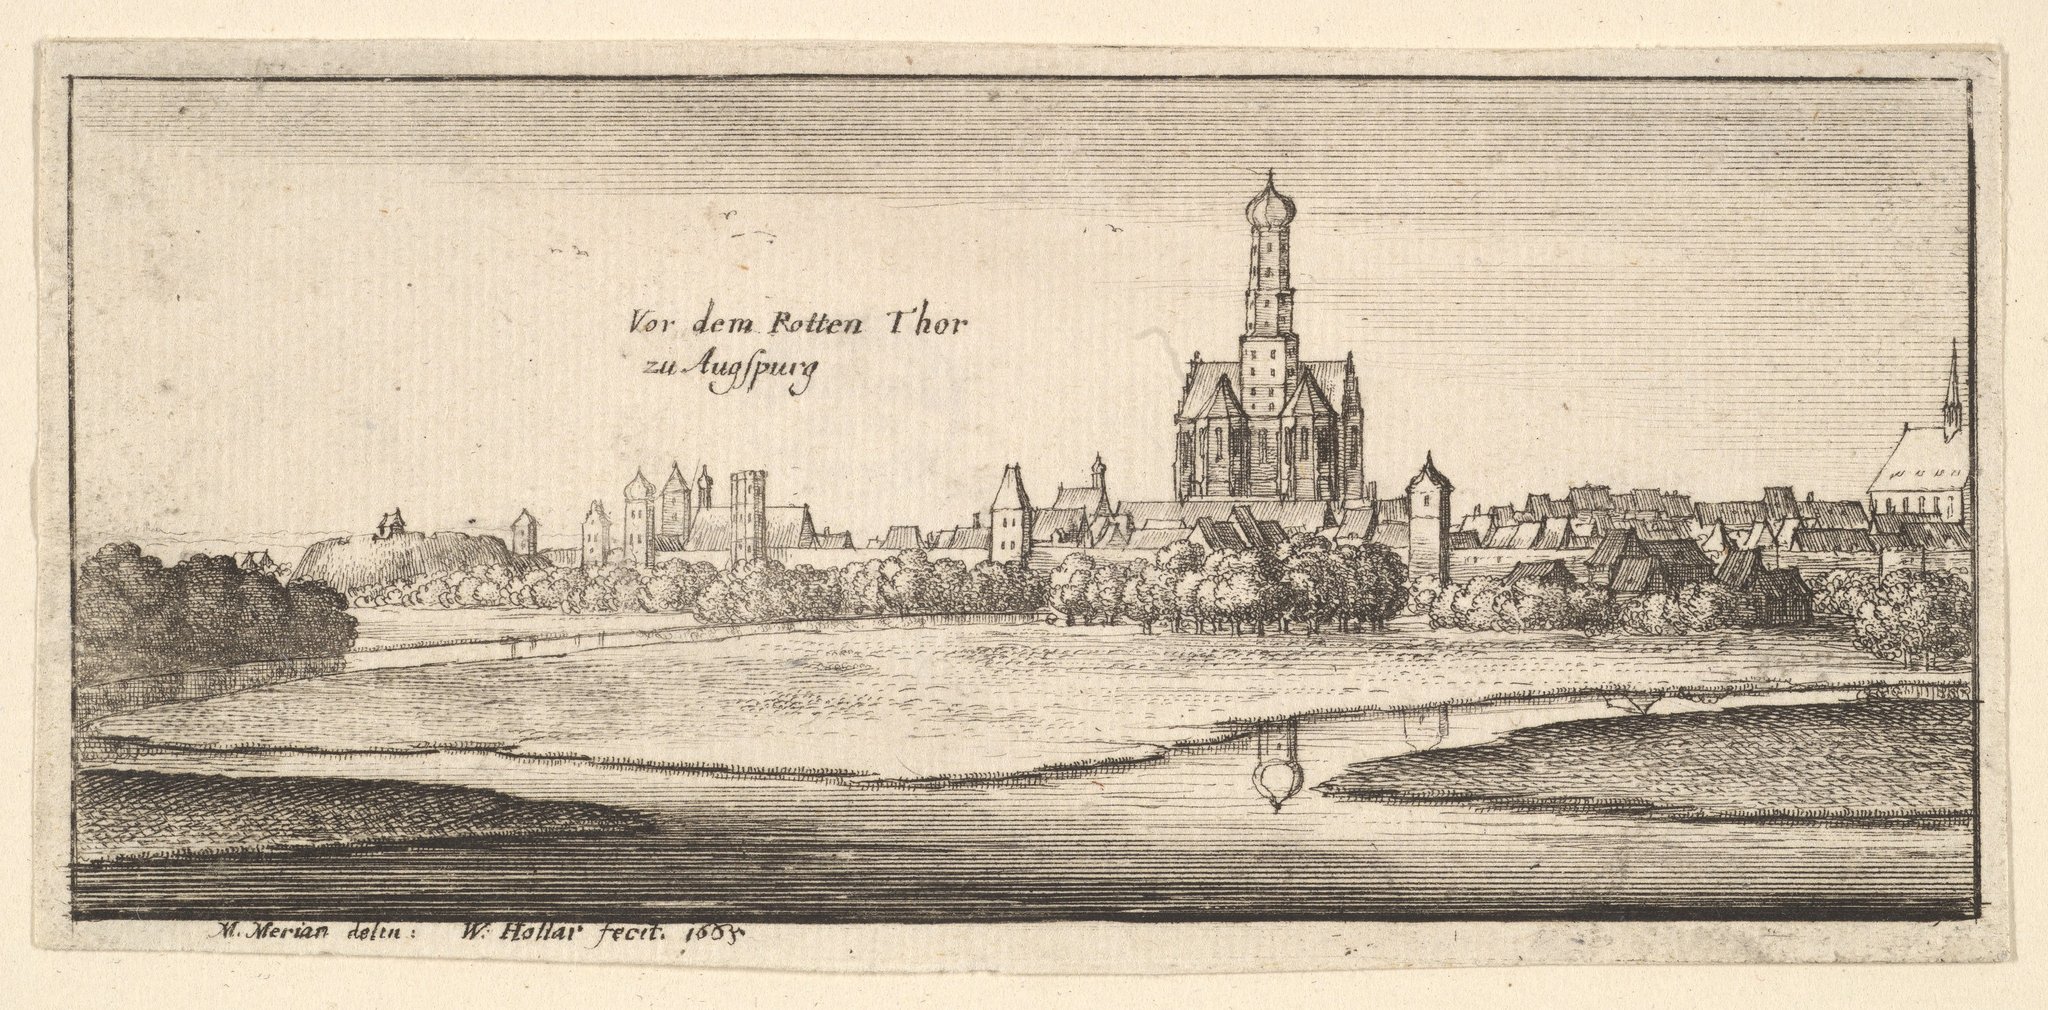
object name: print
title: Augsburg, from "German Views"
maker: wenceslaus hollar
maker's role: artist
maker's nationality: bohemian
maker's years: 1607-1677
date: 1665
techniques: etching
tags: buildings,houses,cities